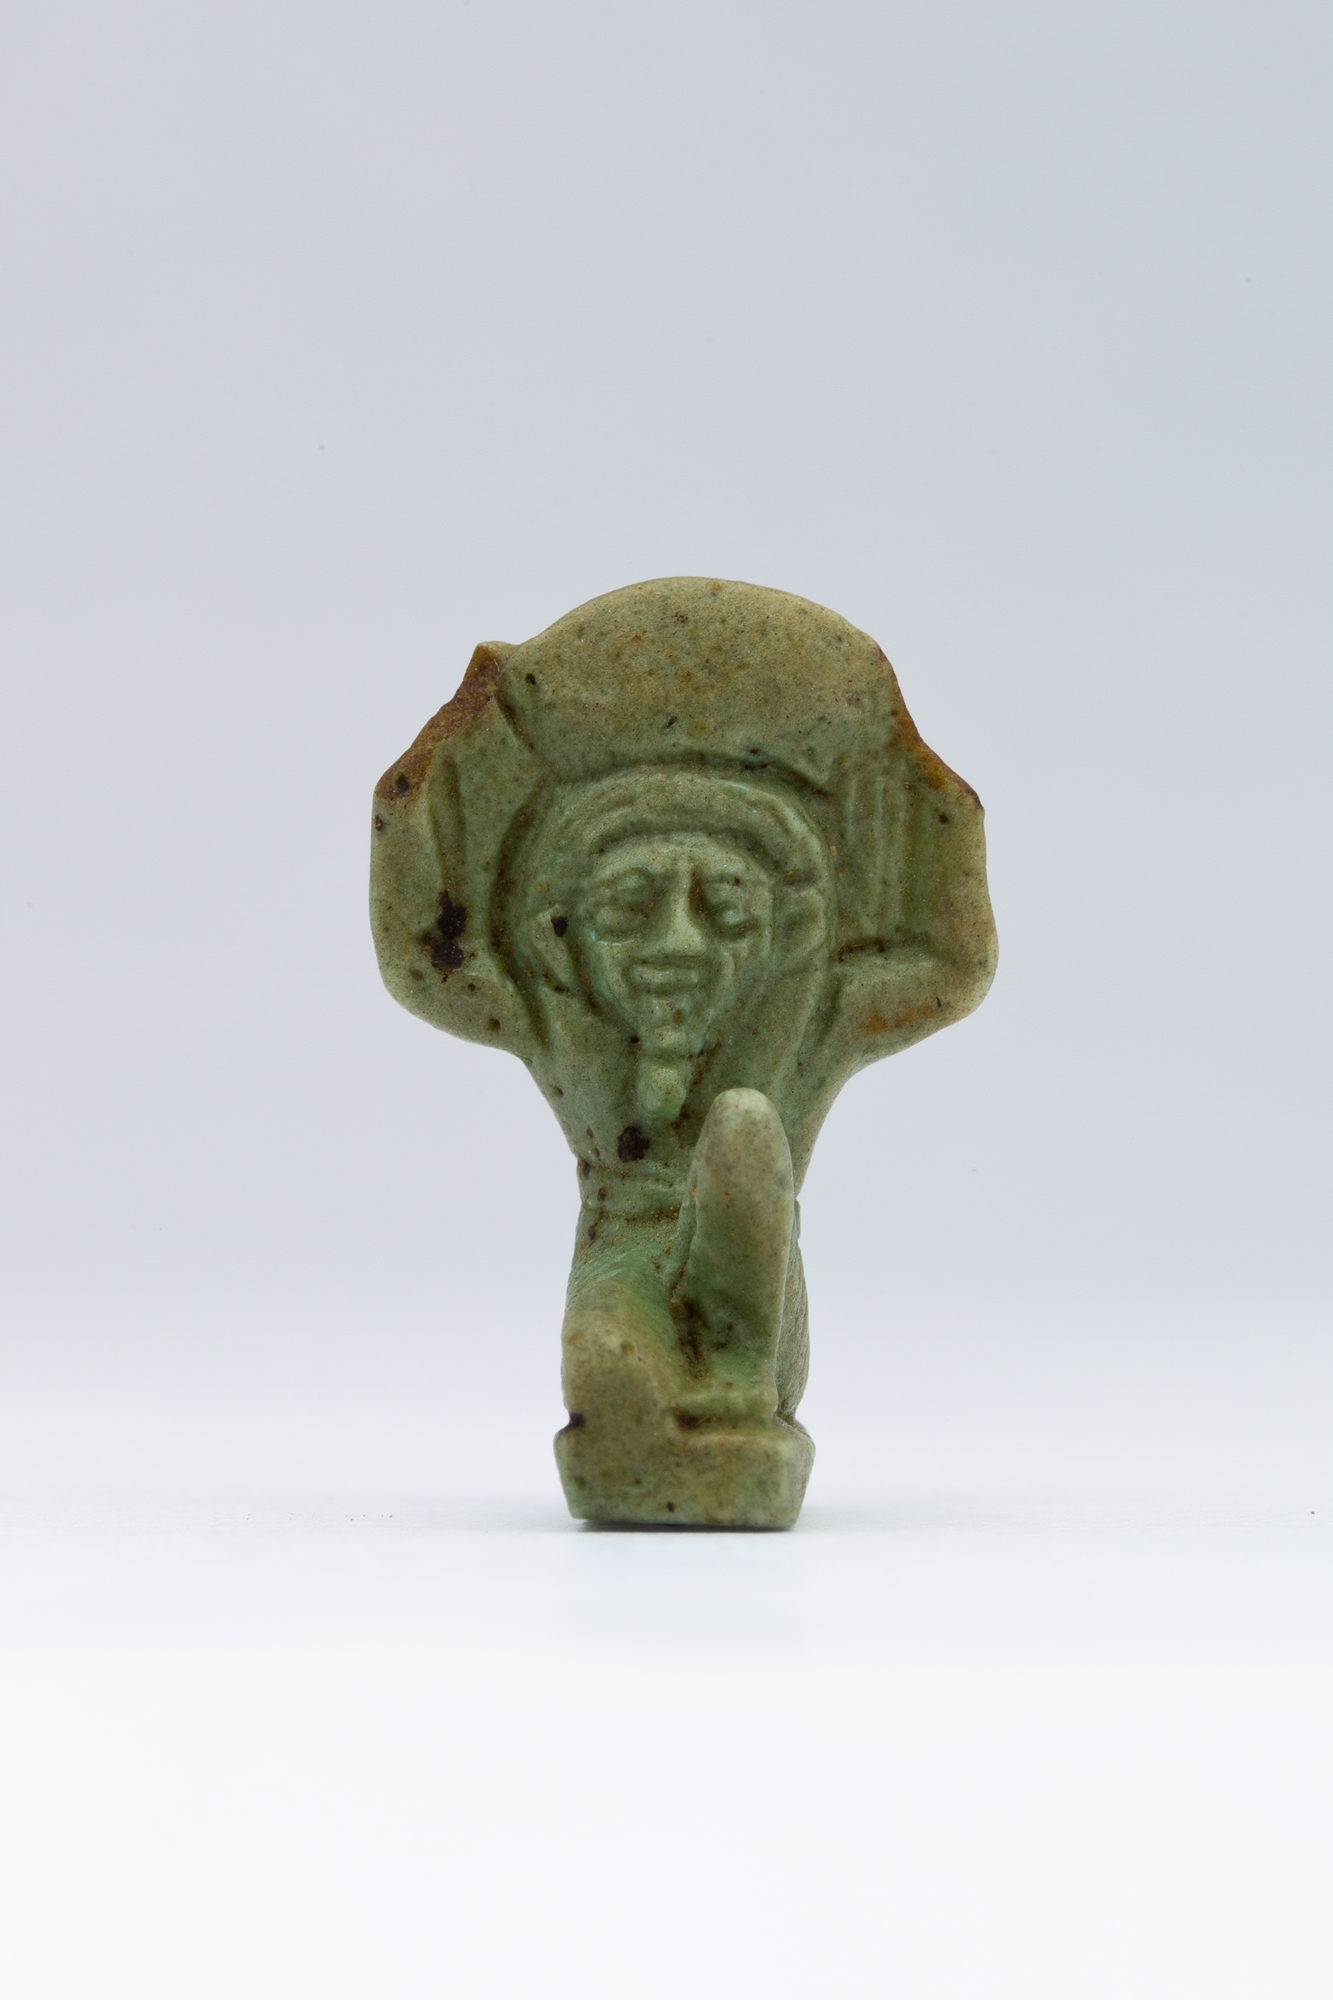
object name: amulet, shu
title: Shu Amulet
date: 664-332 BCE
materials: faience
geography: egypt